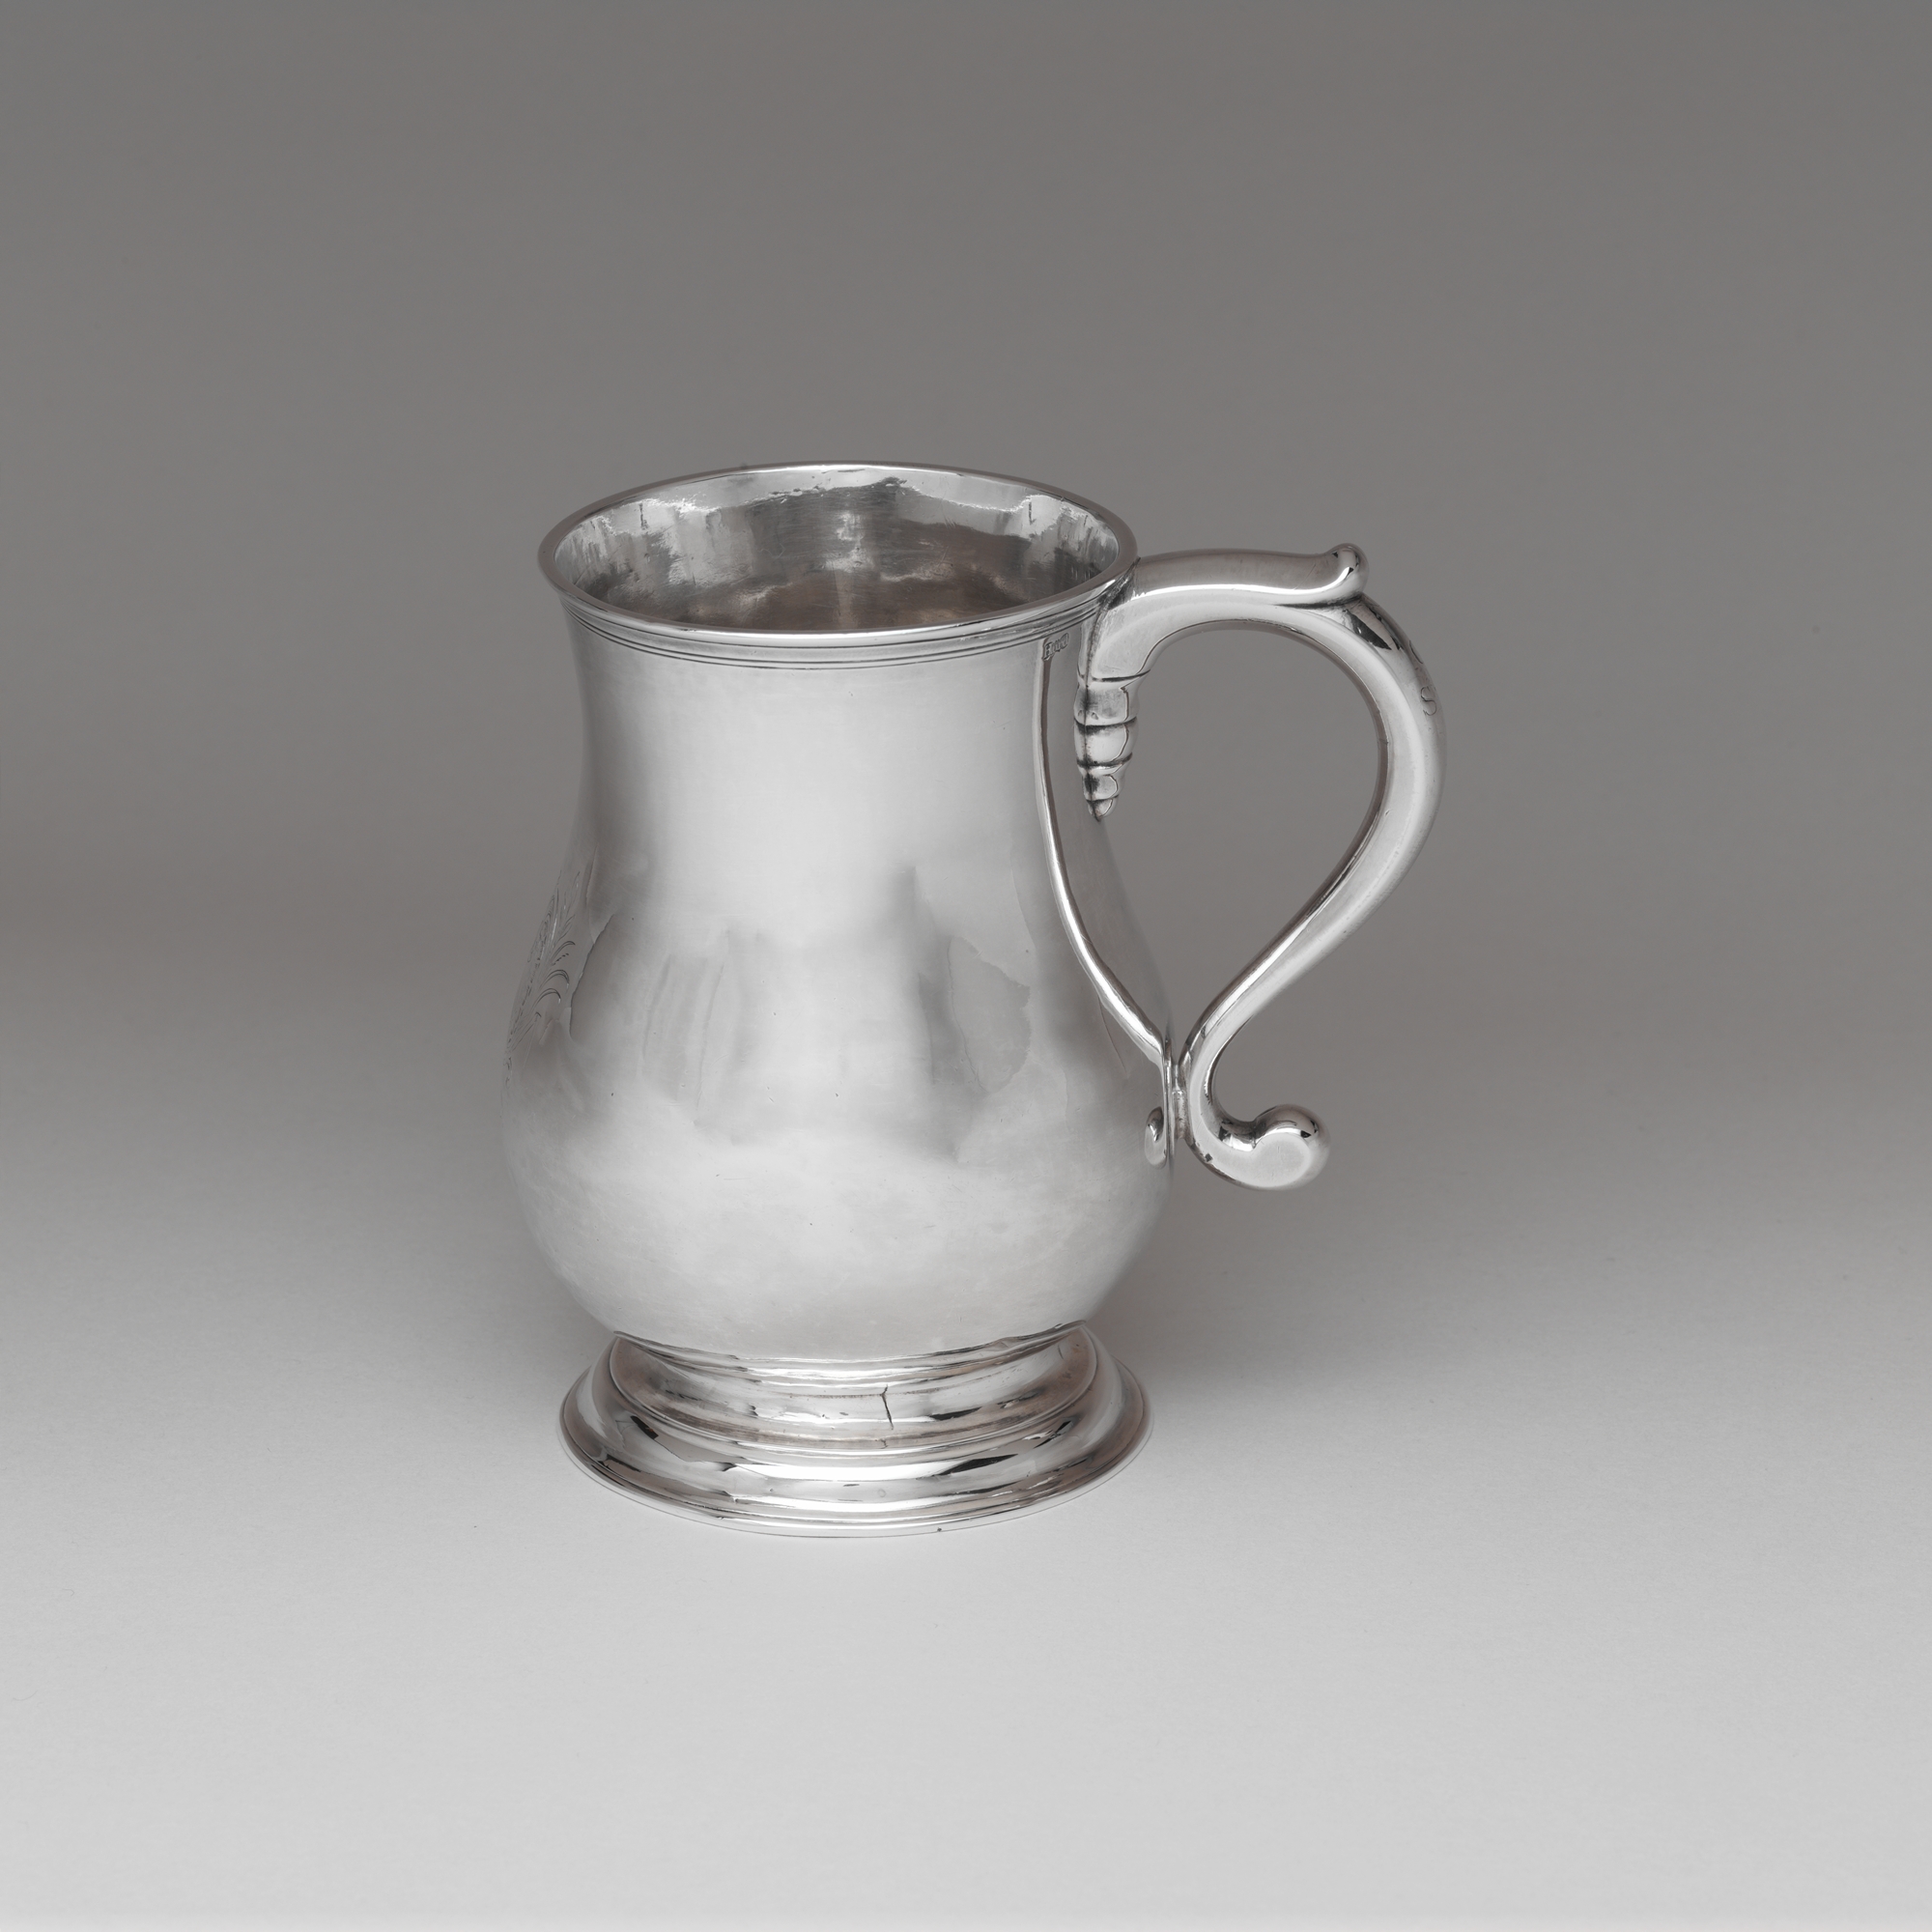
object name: cann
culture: american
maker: jacob hurd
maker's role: maker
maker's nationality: american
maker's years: 1702-1758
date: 1745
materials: silver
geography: united states